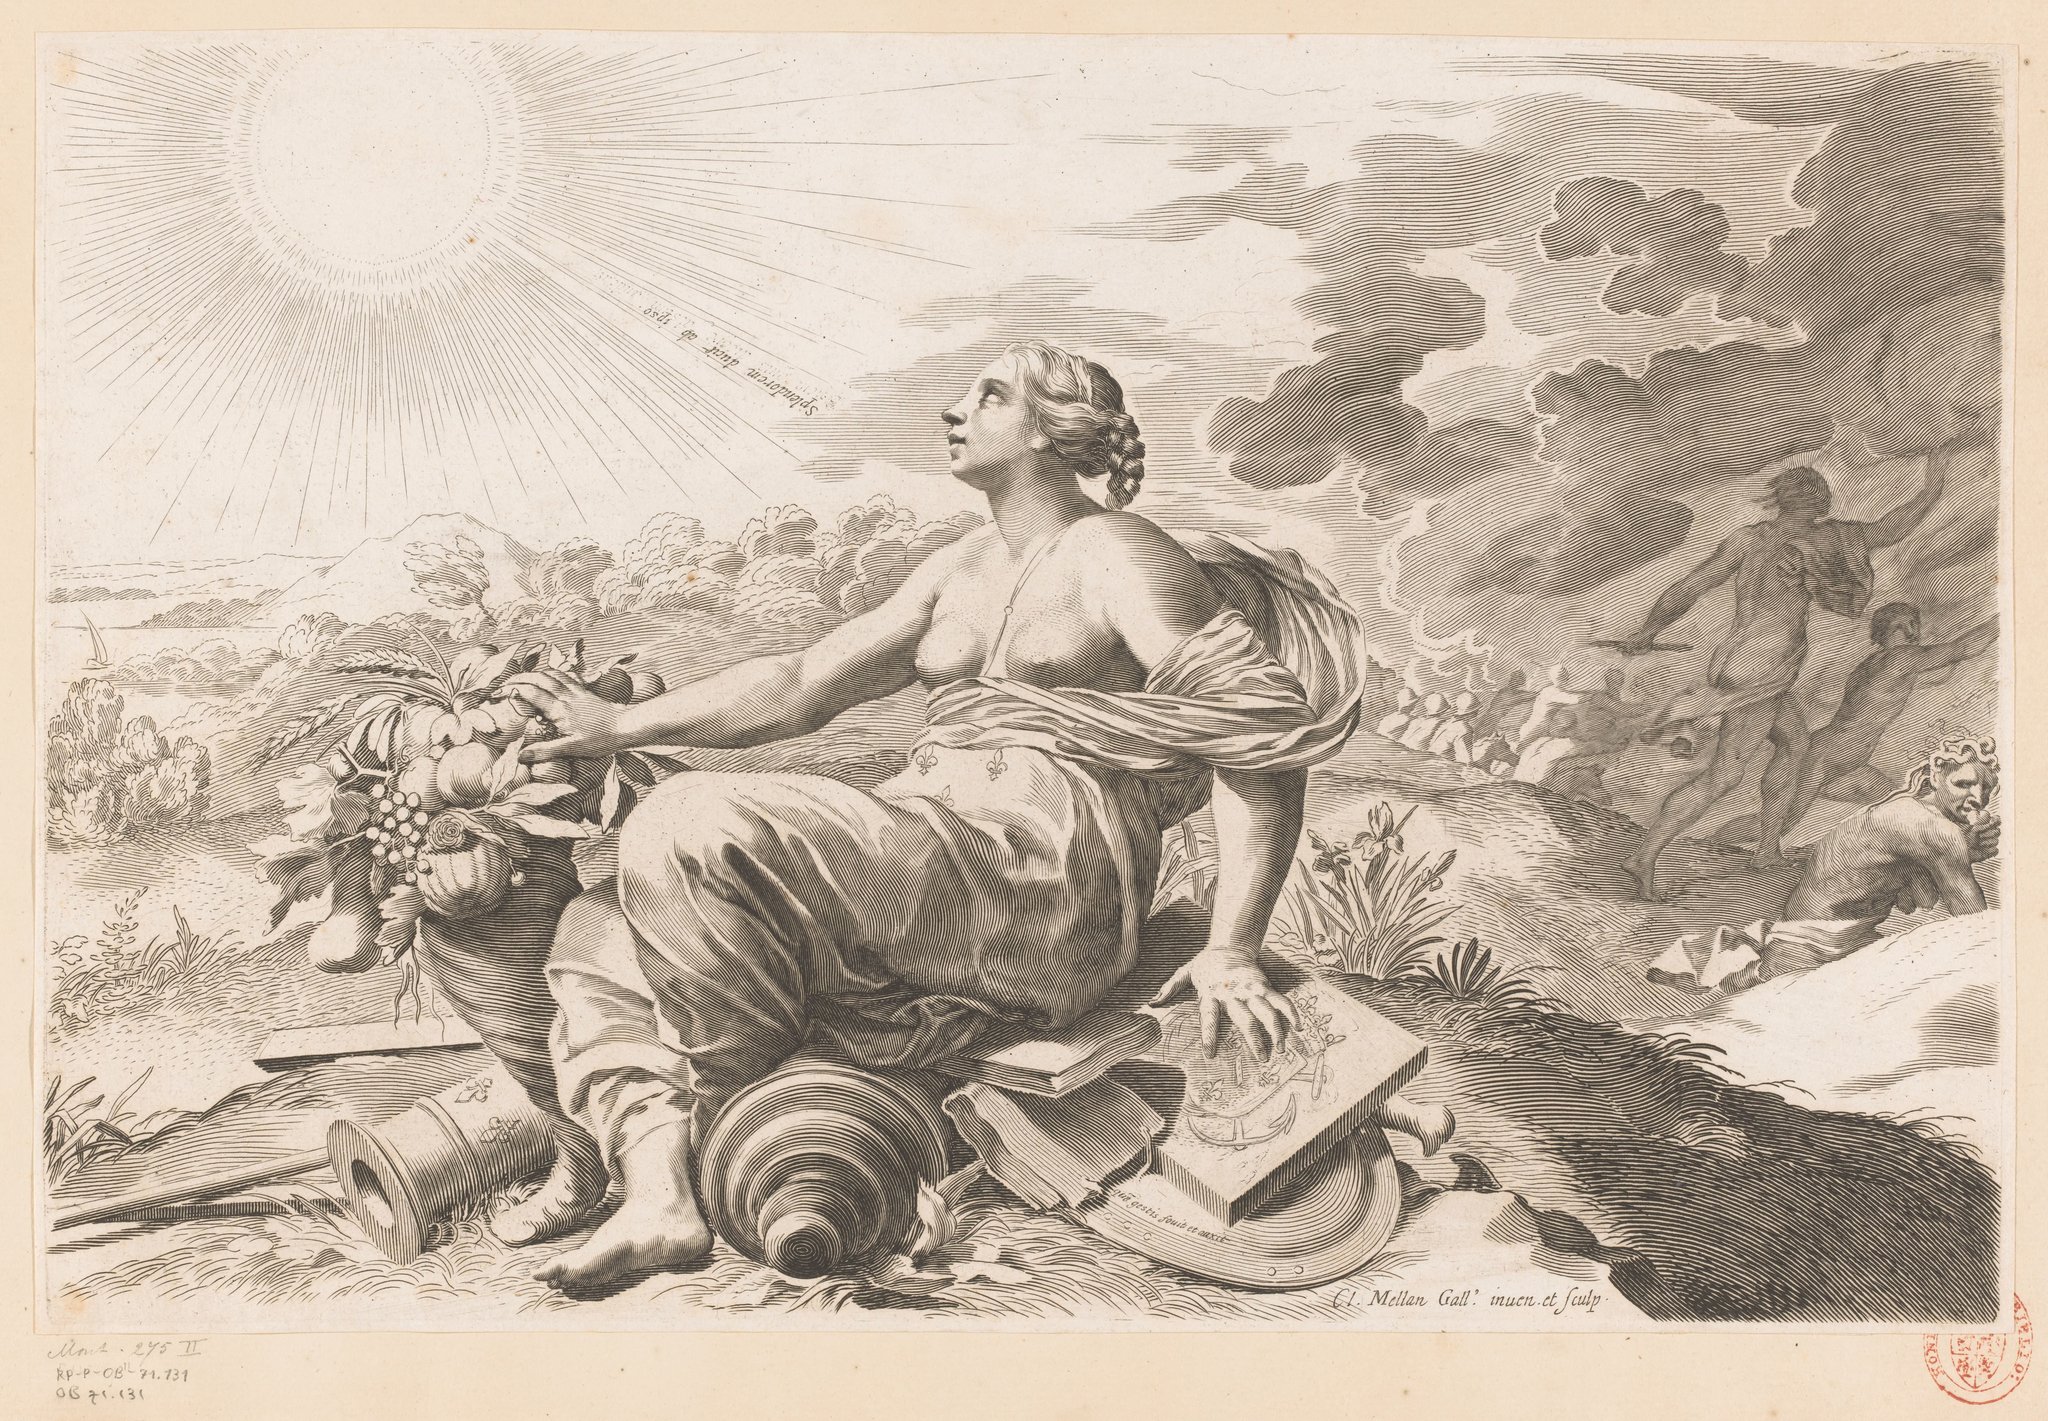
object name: print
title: Allegorie op de vrede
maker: claude mellan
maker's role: draughtsman, print maker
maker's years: 1598-1688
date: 1636-1642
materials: paper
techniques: engraving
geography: france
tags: peace, armorial bearing, heraldry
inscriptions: collector's mark: Lugt 240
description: Personificatie van Frankrijk als vrouw zittend op een kanon en boeken, hoorn des overvloeds en de hand op het wapenschild van de hertog van Beaufort.